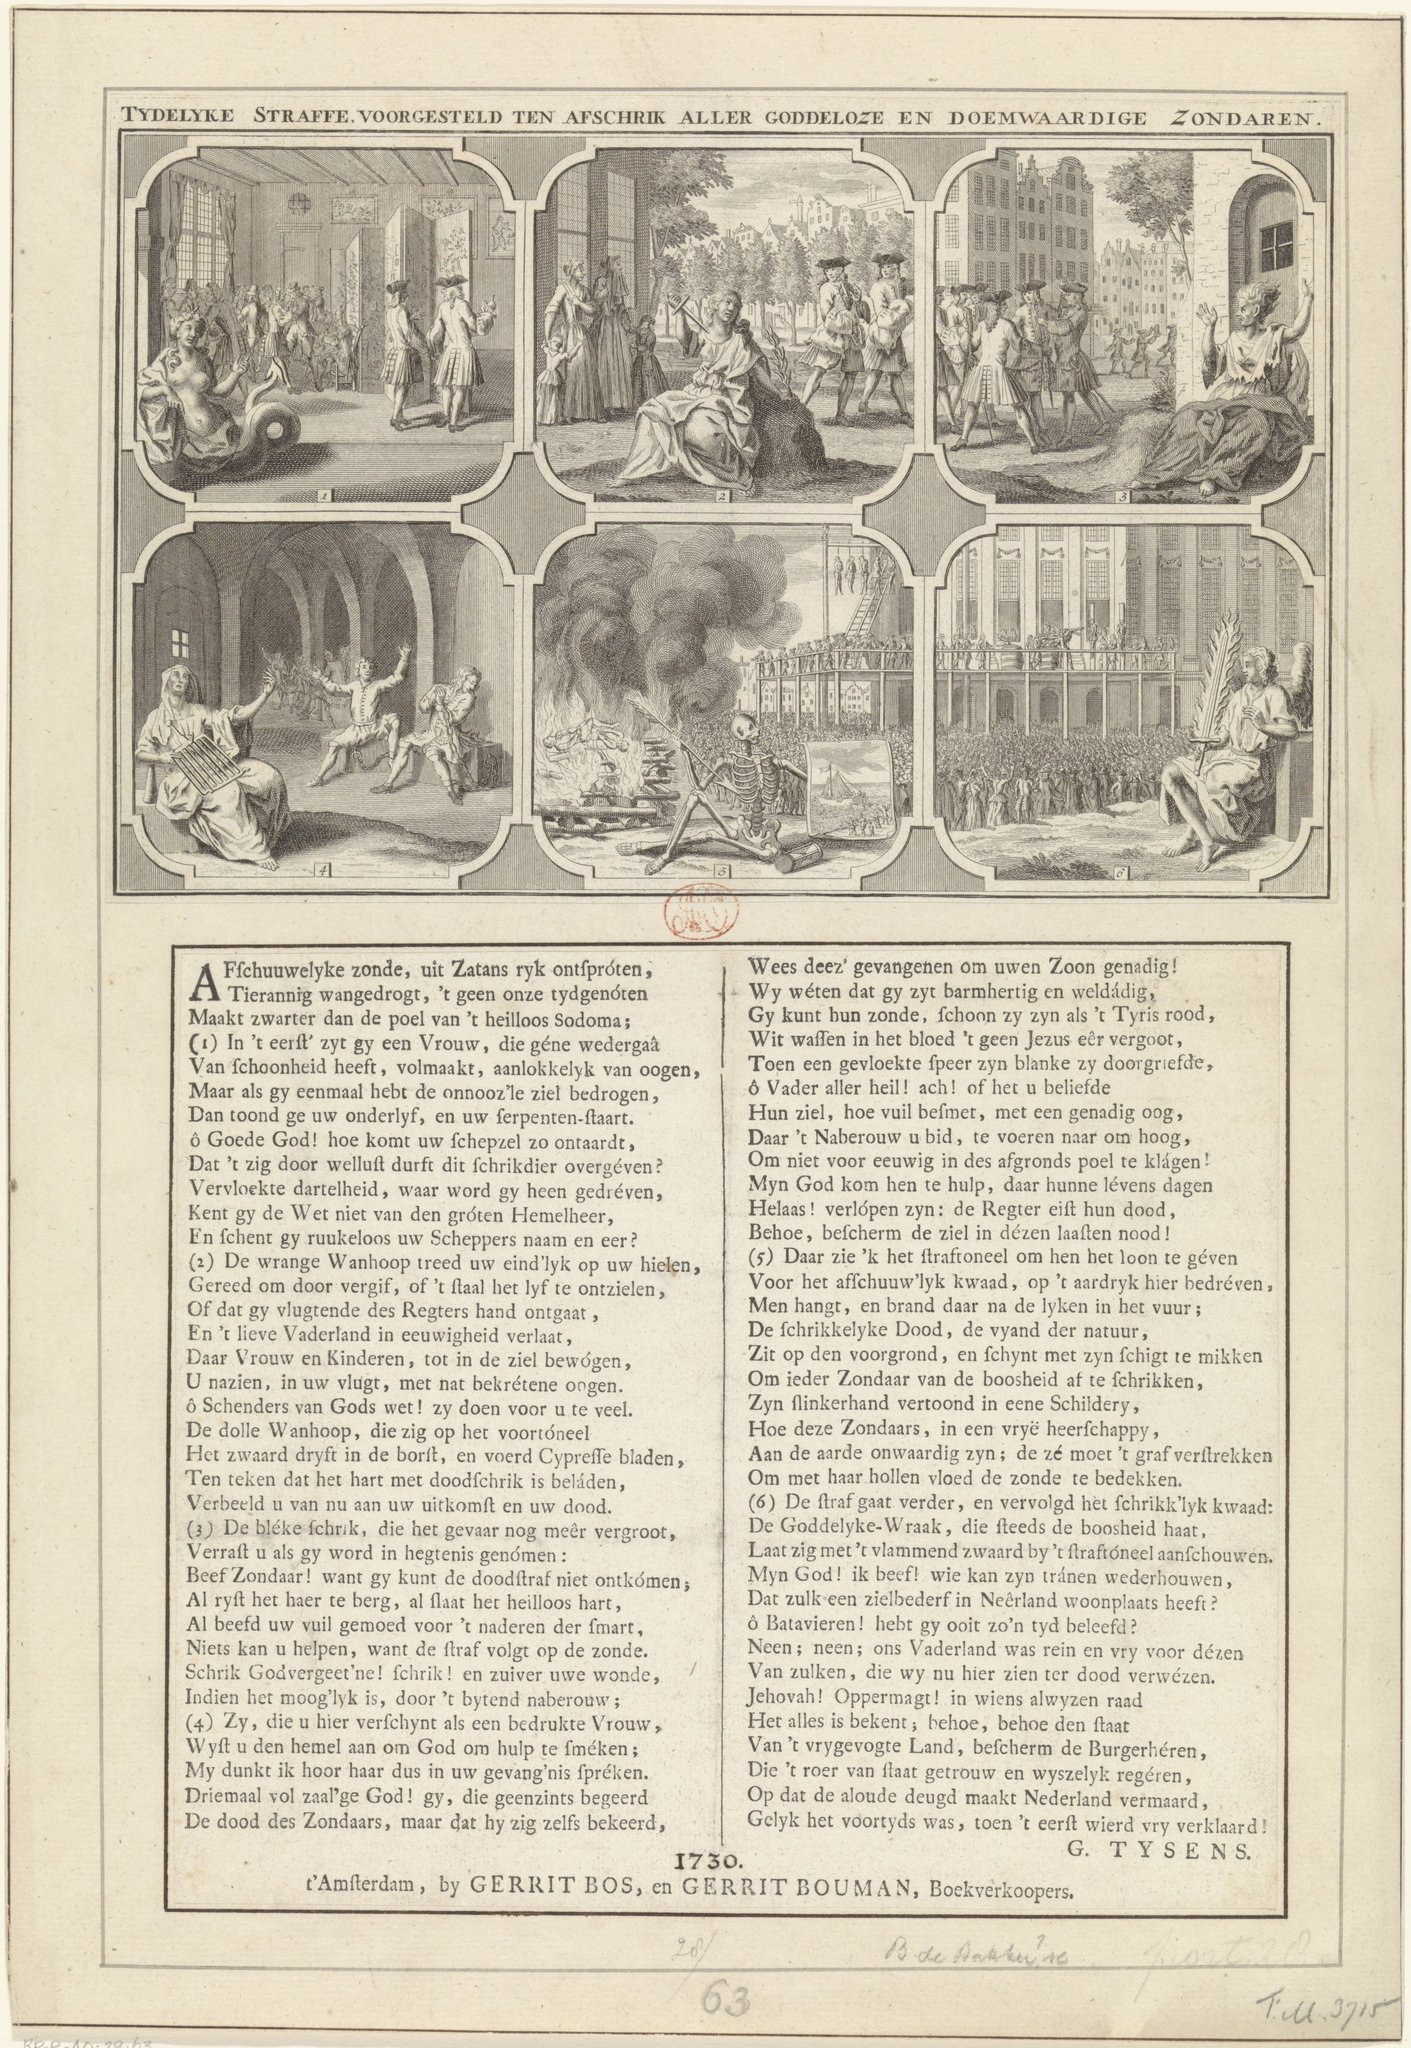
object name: print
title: Allegorical Print with Six Punishments for the Crime of Sodomy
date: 1730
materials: paper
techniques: engraving, etching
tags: sodomy, sexual contact between men, crime, sodomy, sexual contact between humans and animals, criminal law; punishment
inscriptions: collector's mark: Lugt 195, inscription: ‘28/63’, collector's mark: Lugt 2228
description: The six images and accompanying text show what men faced if they succumbed to the temptation of having sex together. The print was made in 1730, when more than 300 men in the Dutch Republic were prosecuted for sex between men (sodomy), at least 75 of whom received the death penalty. The punishments had to be carried out in public and were depicted in prints like this one to serve as a deterrent. Sex between men was explicitly criminalised and declared a sin.